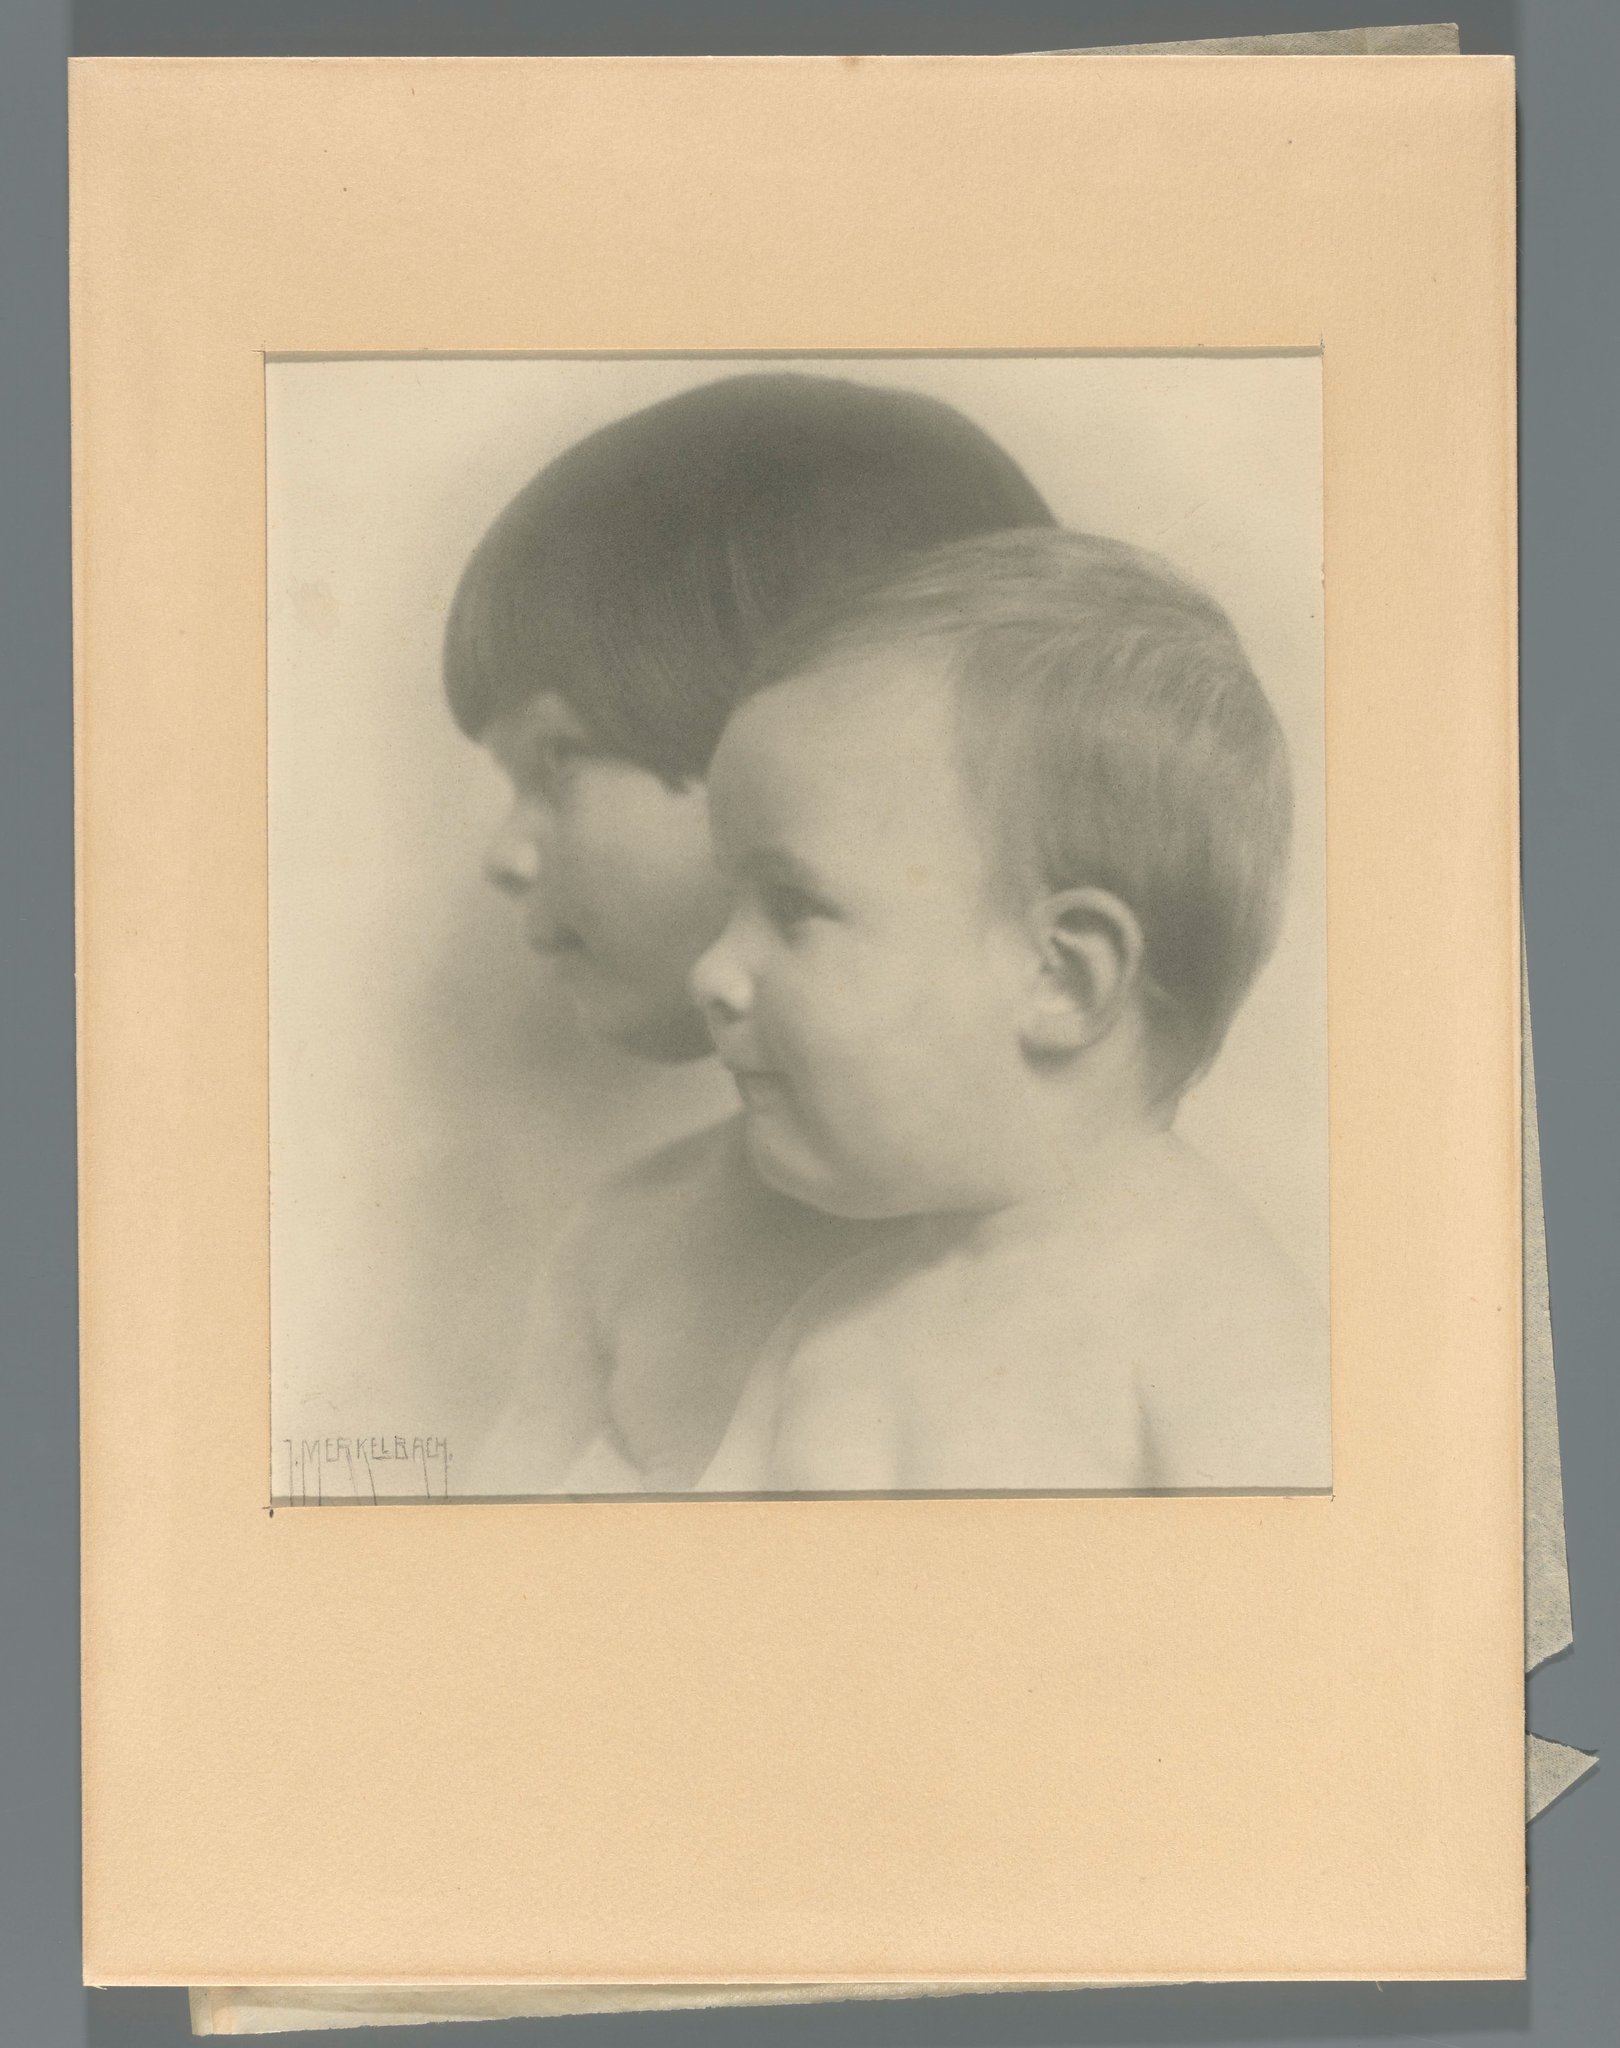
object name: photograph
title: Portret van twee peuters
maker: jacob merkelbach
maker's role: fotograaf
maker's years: 1877-1942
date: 1920-1930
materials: paper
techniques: bromoil process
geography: amsterdam